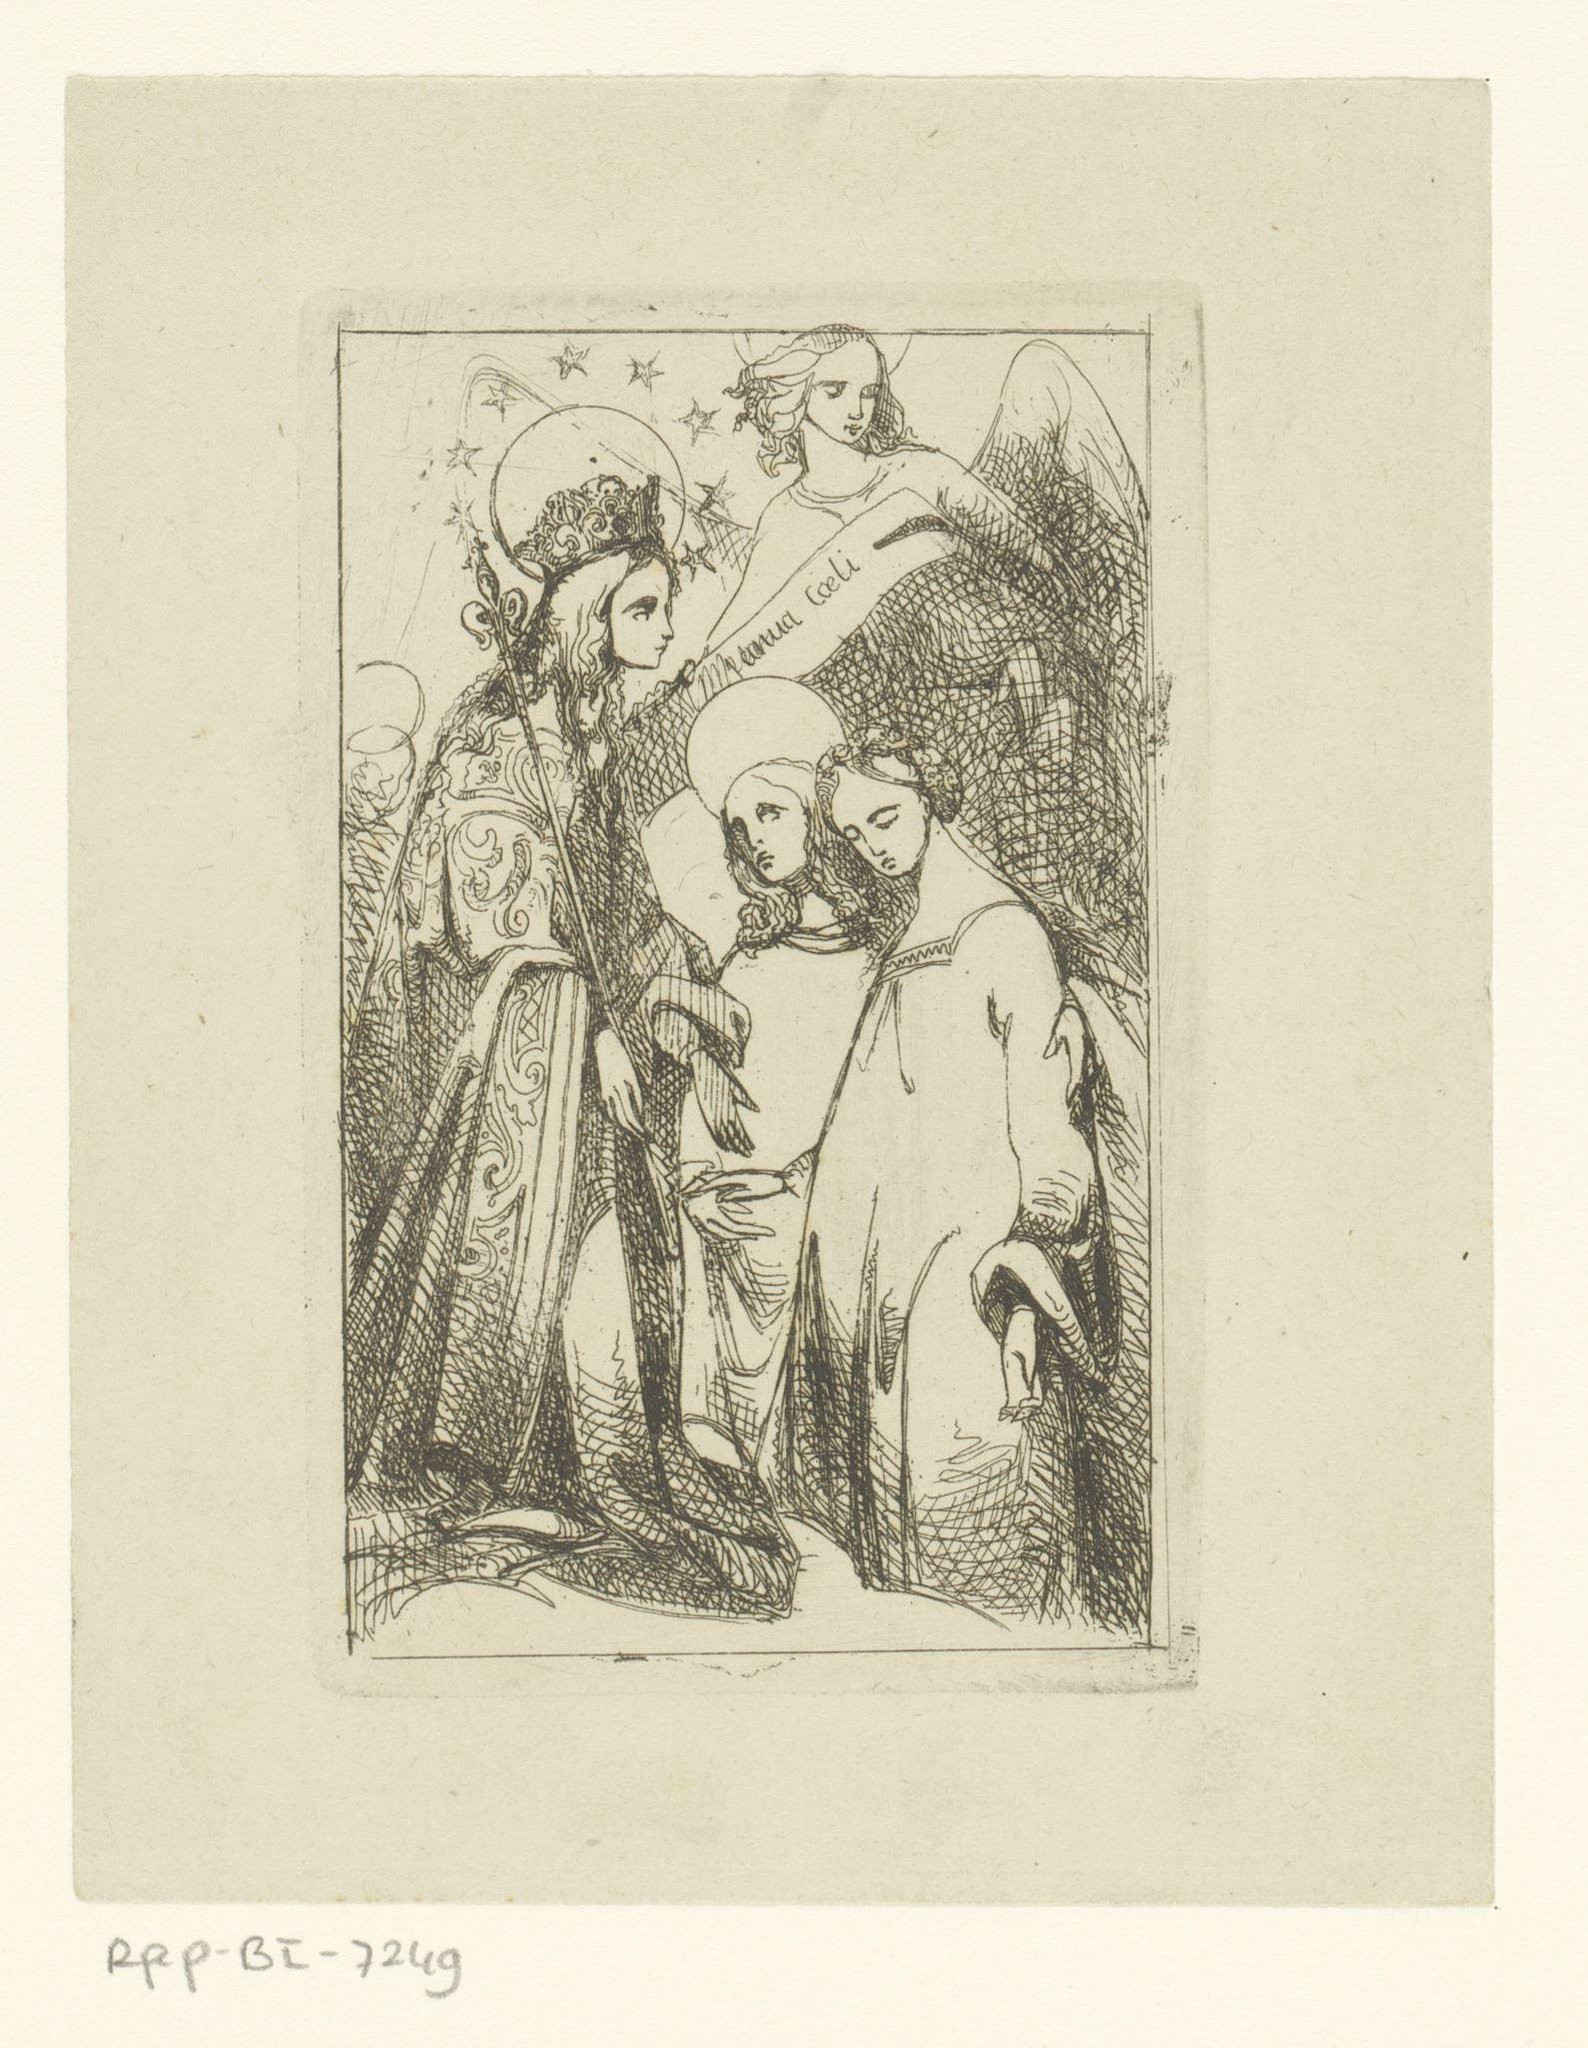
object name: print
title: Twee engelen leiden een vrouw voor Maria in de hemel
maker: franciscus andreas durlet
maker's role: draughtsman, print maker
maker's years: 1816-1867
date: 1844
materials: paper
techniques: etching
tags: (ascent into) heaven, the virgin mary, angels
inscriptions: collector's mark: Lugt 2228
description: Een latere staat van deze prent bevat op de achterzijde een overlijdensbericht van de zus van de prentmaker: Agnes Jeanne Durlet. Mogelijk stelt de vrouwenfiguur Agnes Jeanne voor die na haar overlijden in 1844 voor Maria in de hemel zou verschijnen.